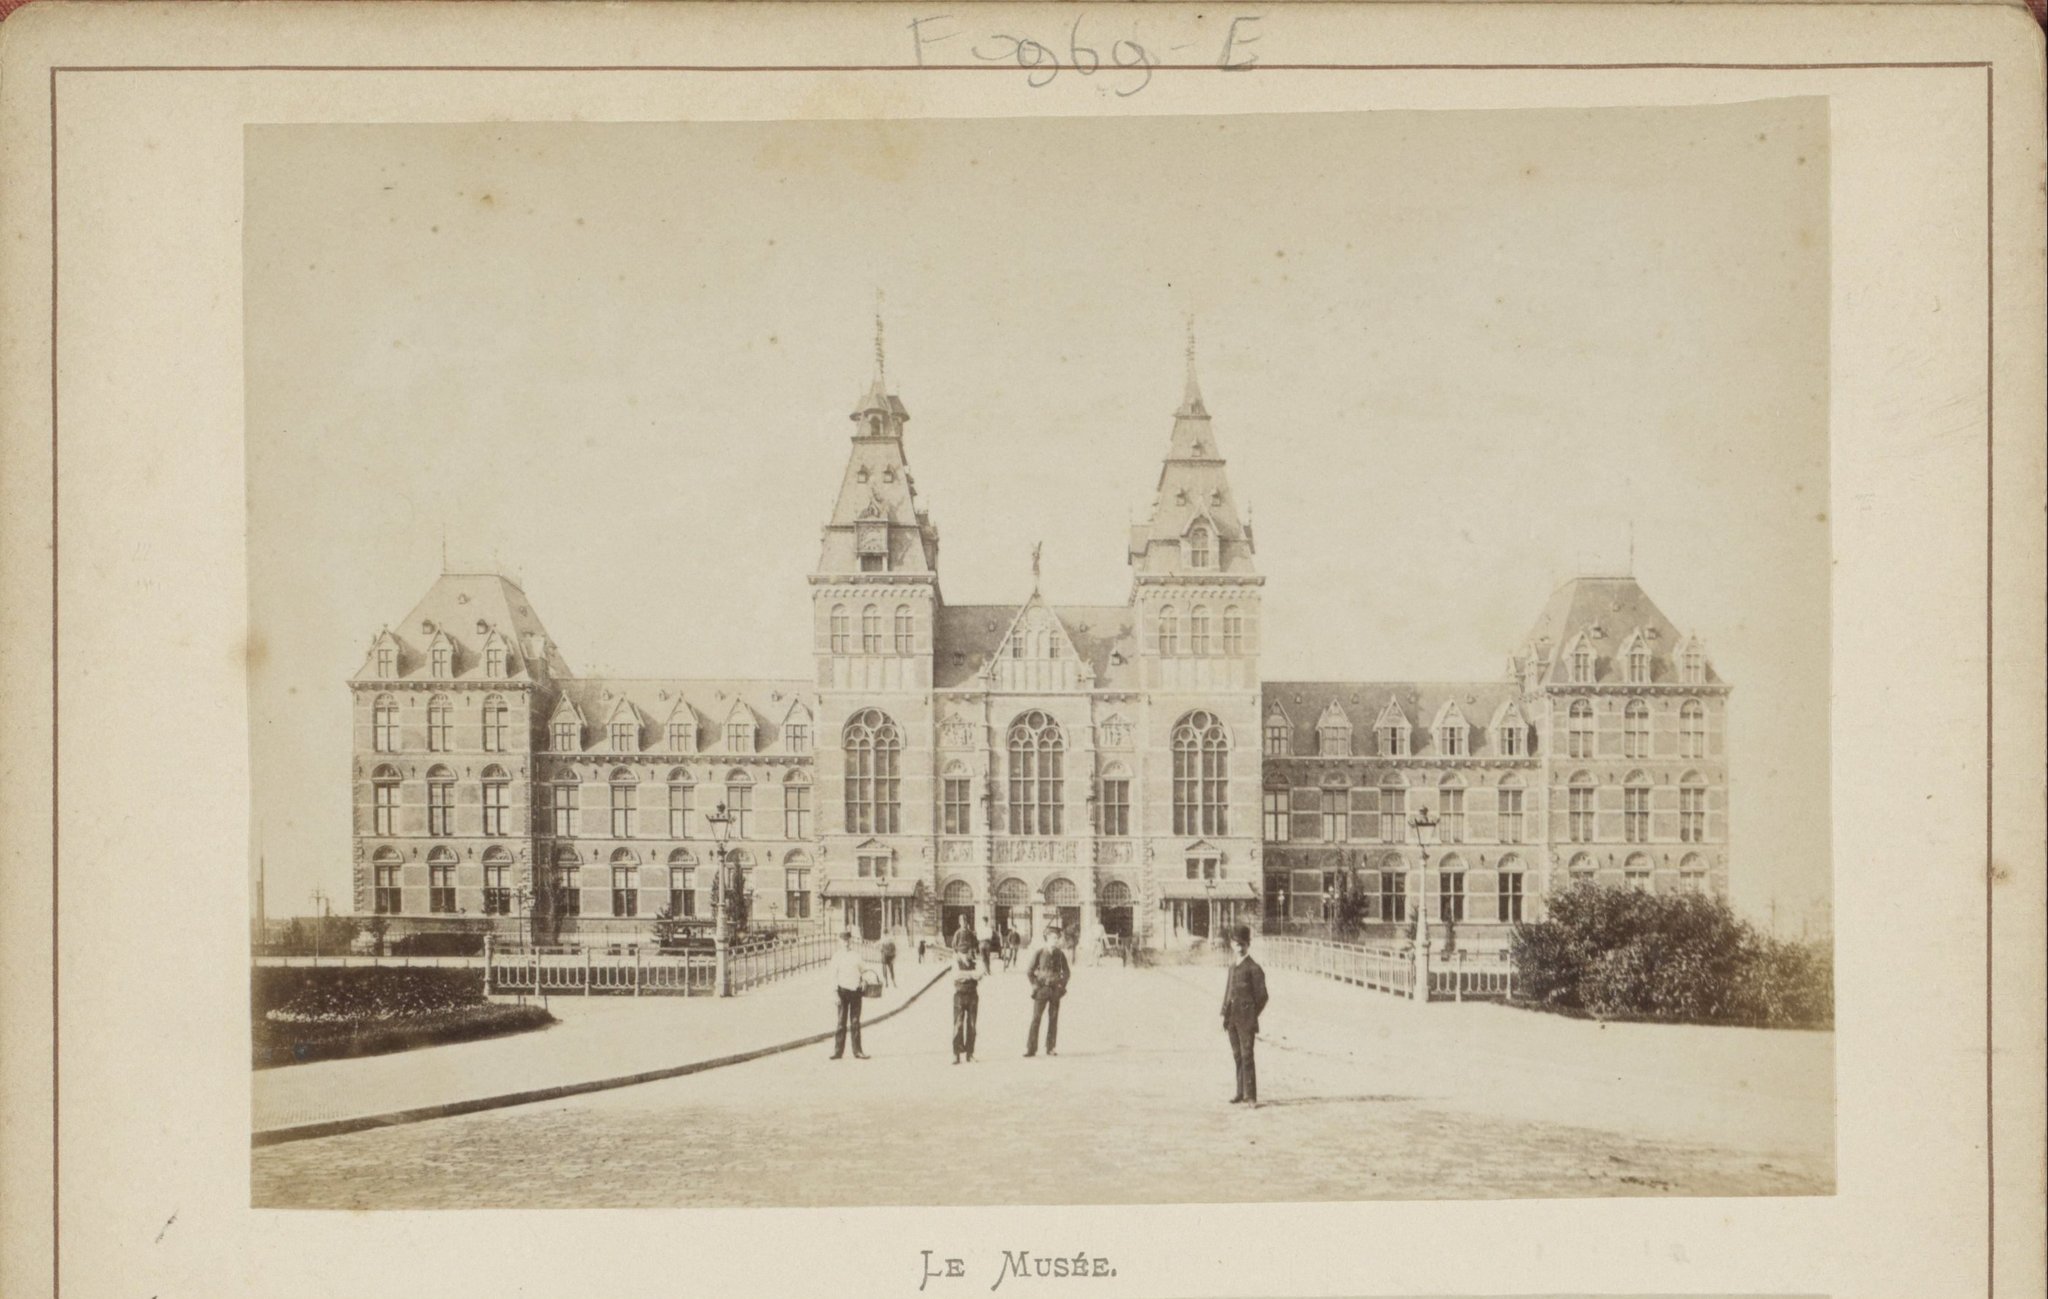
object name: photograph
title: Gezicht op de noordgevel van het Rijksmuseum en de Museumbrug in Amsterdam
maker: andries jager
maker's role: publisher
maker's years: 1825-1905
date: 1885-1910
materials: cardboard, paper, photographic support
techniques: albumen print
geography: amsterdam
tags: permanent exhibition, museum, façade (of house or building), bridge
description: Onderdeel van Leporelloalbum met 28 foto's van Amsterdam en omstreken.